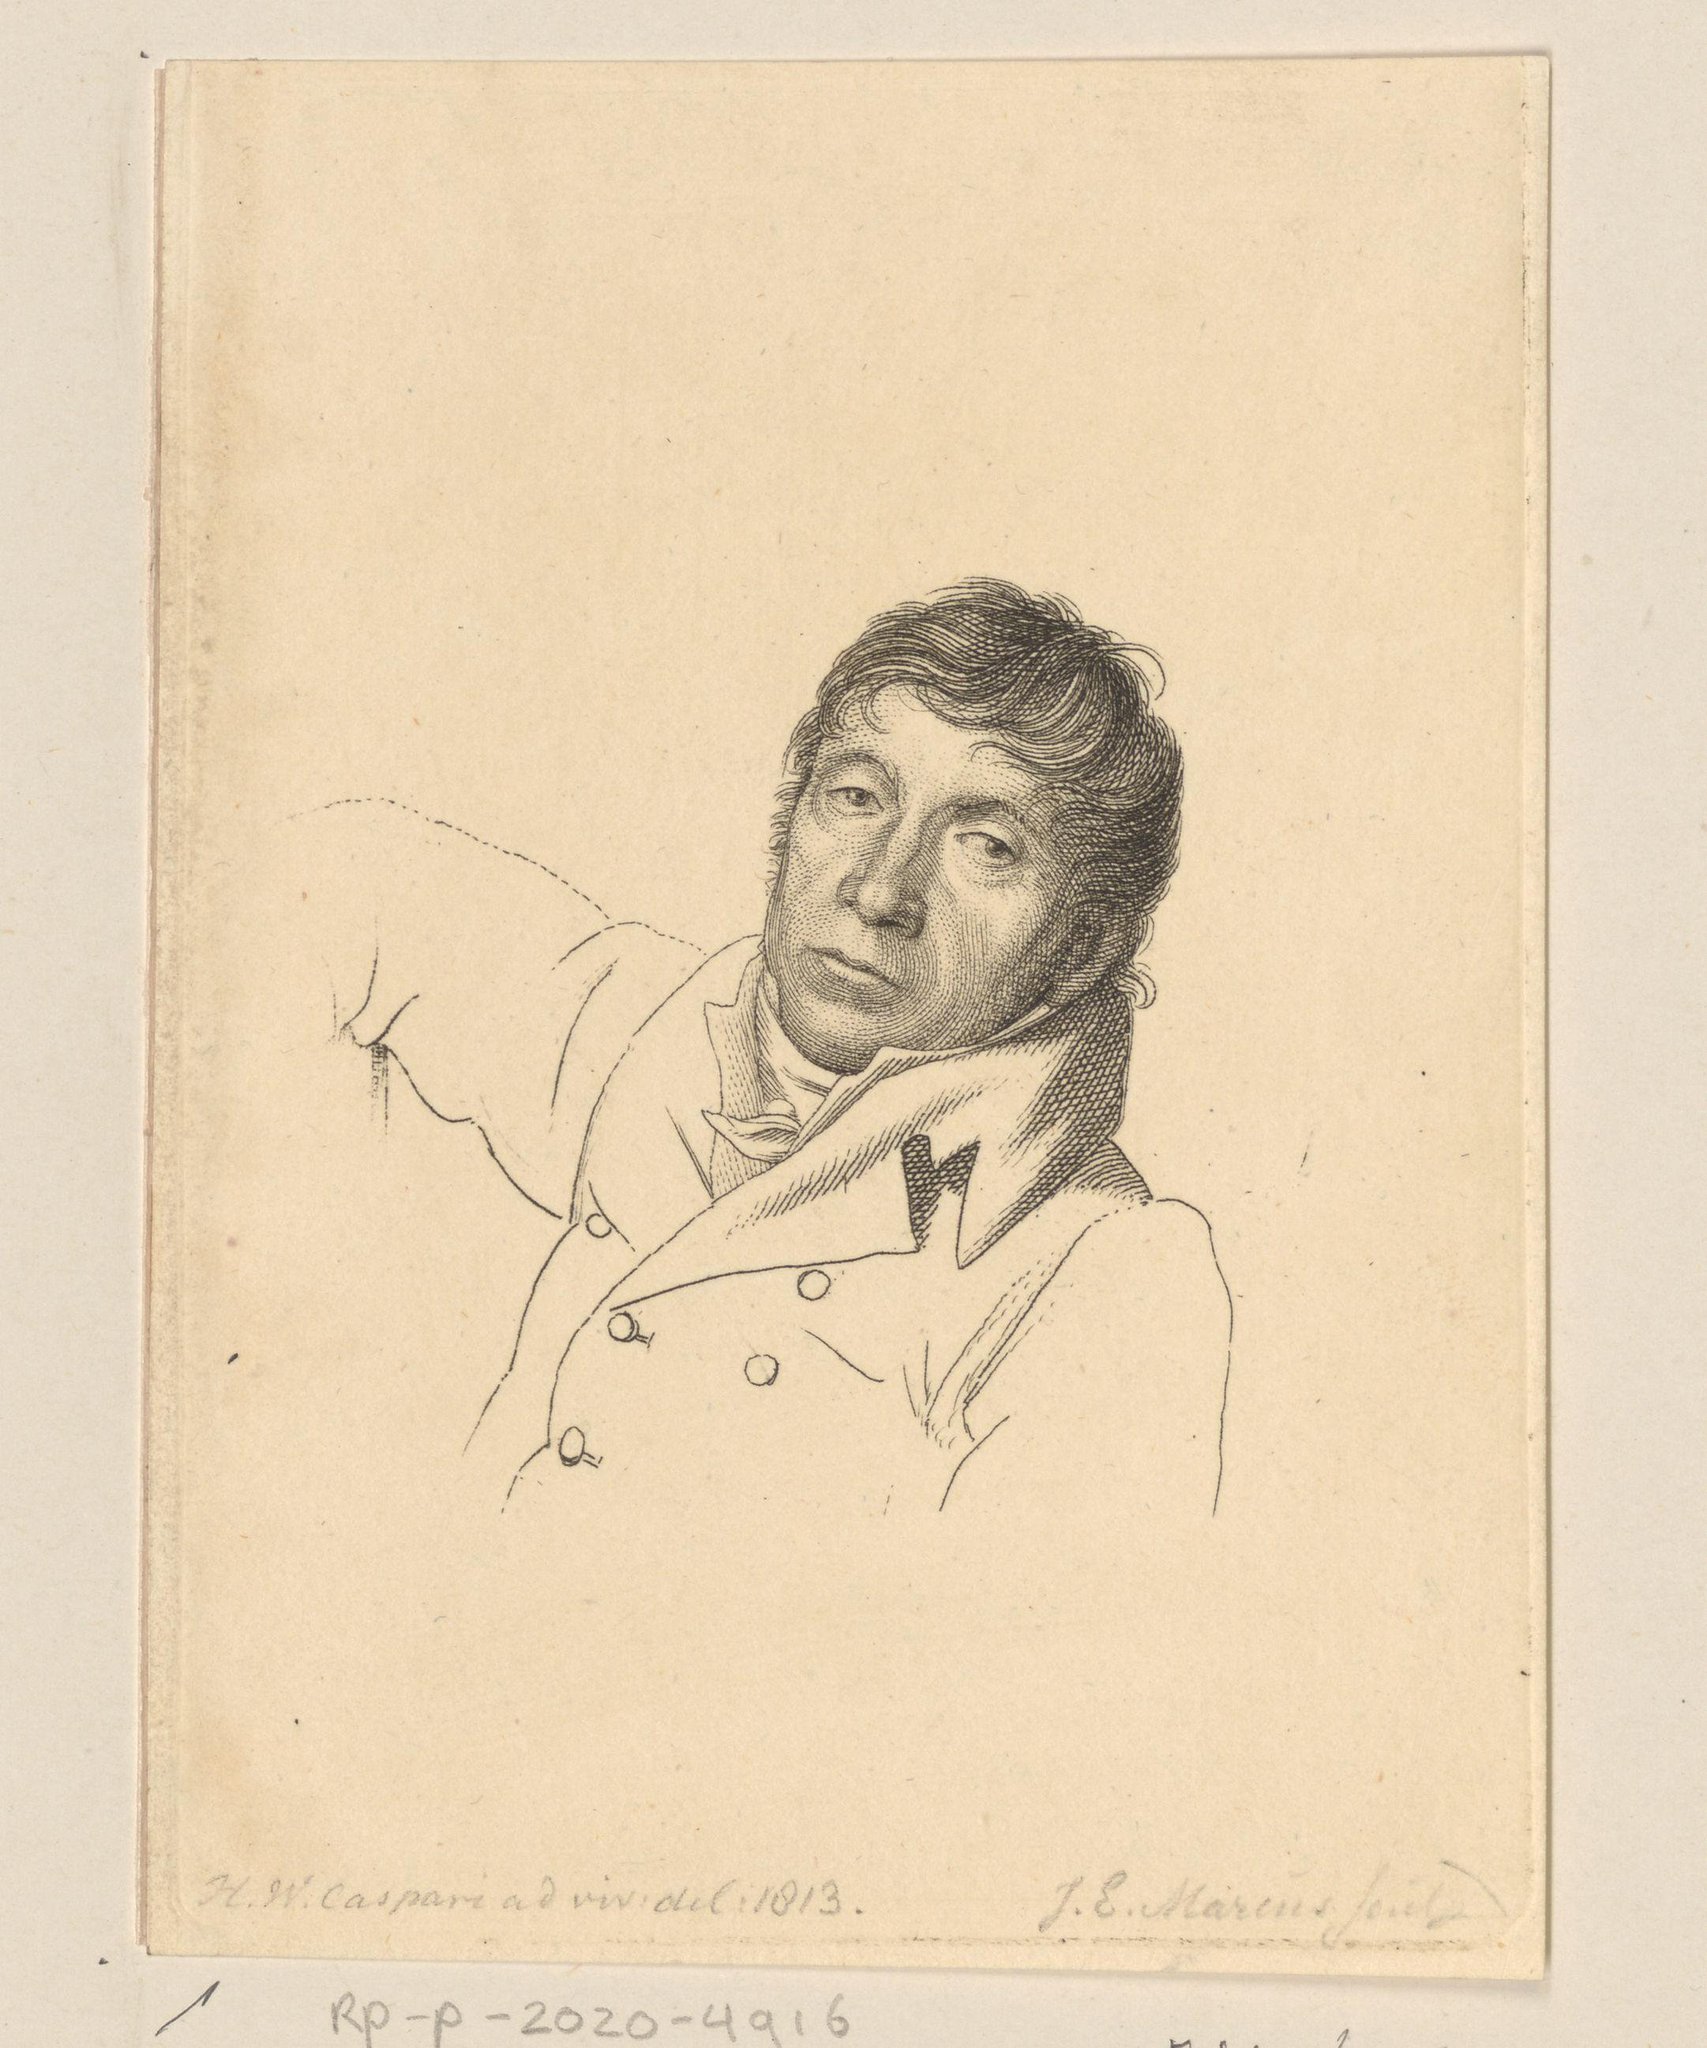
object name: print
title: Portret van Hendrik de Flines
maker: jacob ernst marcus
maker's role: draughtsman, print maker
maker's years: 1774-1826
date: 1814-1820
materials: paper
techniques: etching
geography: amsterdam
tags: hendrik de flines, historical persons, portrait of a writer, portrait, self-portrait of artist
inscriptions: collector's mark: Lugt 2228, inscription: ‘H.W. Caspari ad viv: del: 1813. J.E. Marcus fecit’, inscription: ‘H: de Flines/ Kunstminn:’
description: In eerdere staat uitgegeven voor de serie Studie-prentwerk/ Etudes gravées, op één plaat met de portretten van Jan Kamphuysen en Dirk Versteegh.